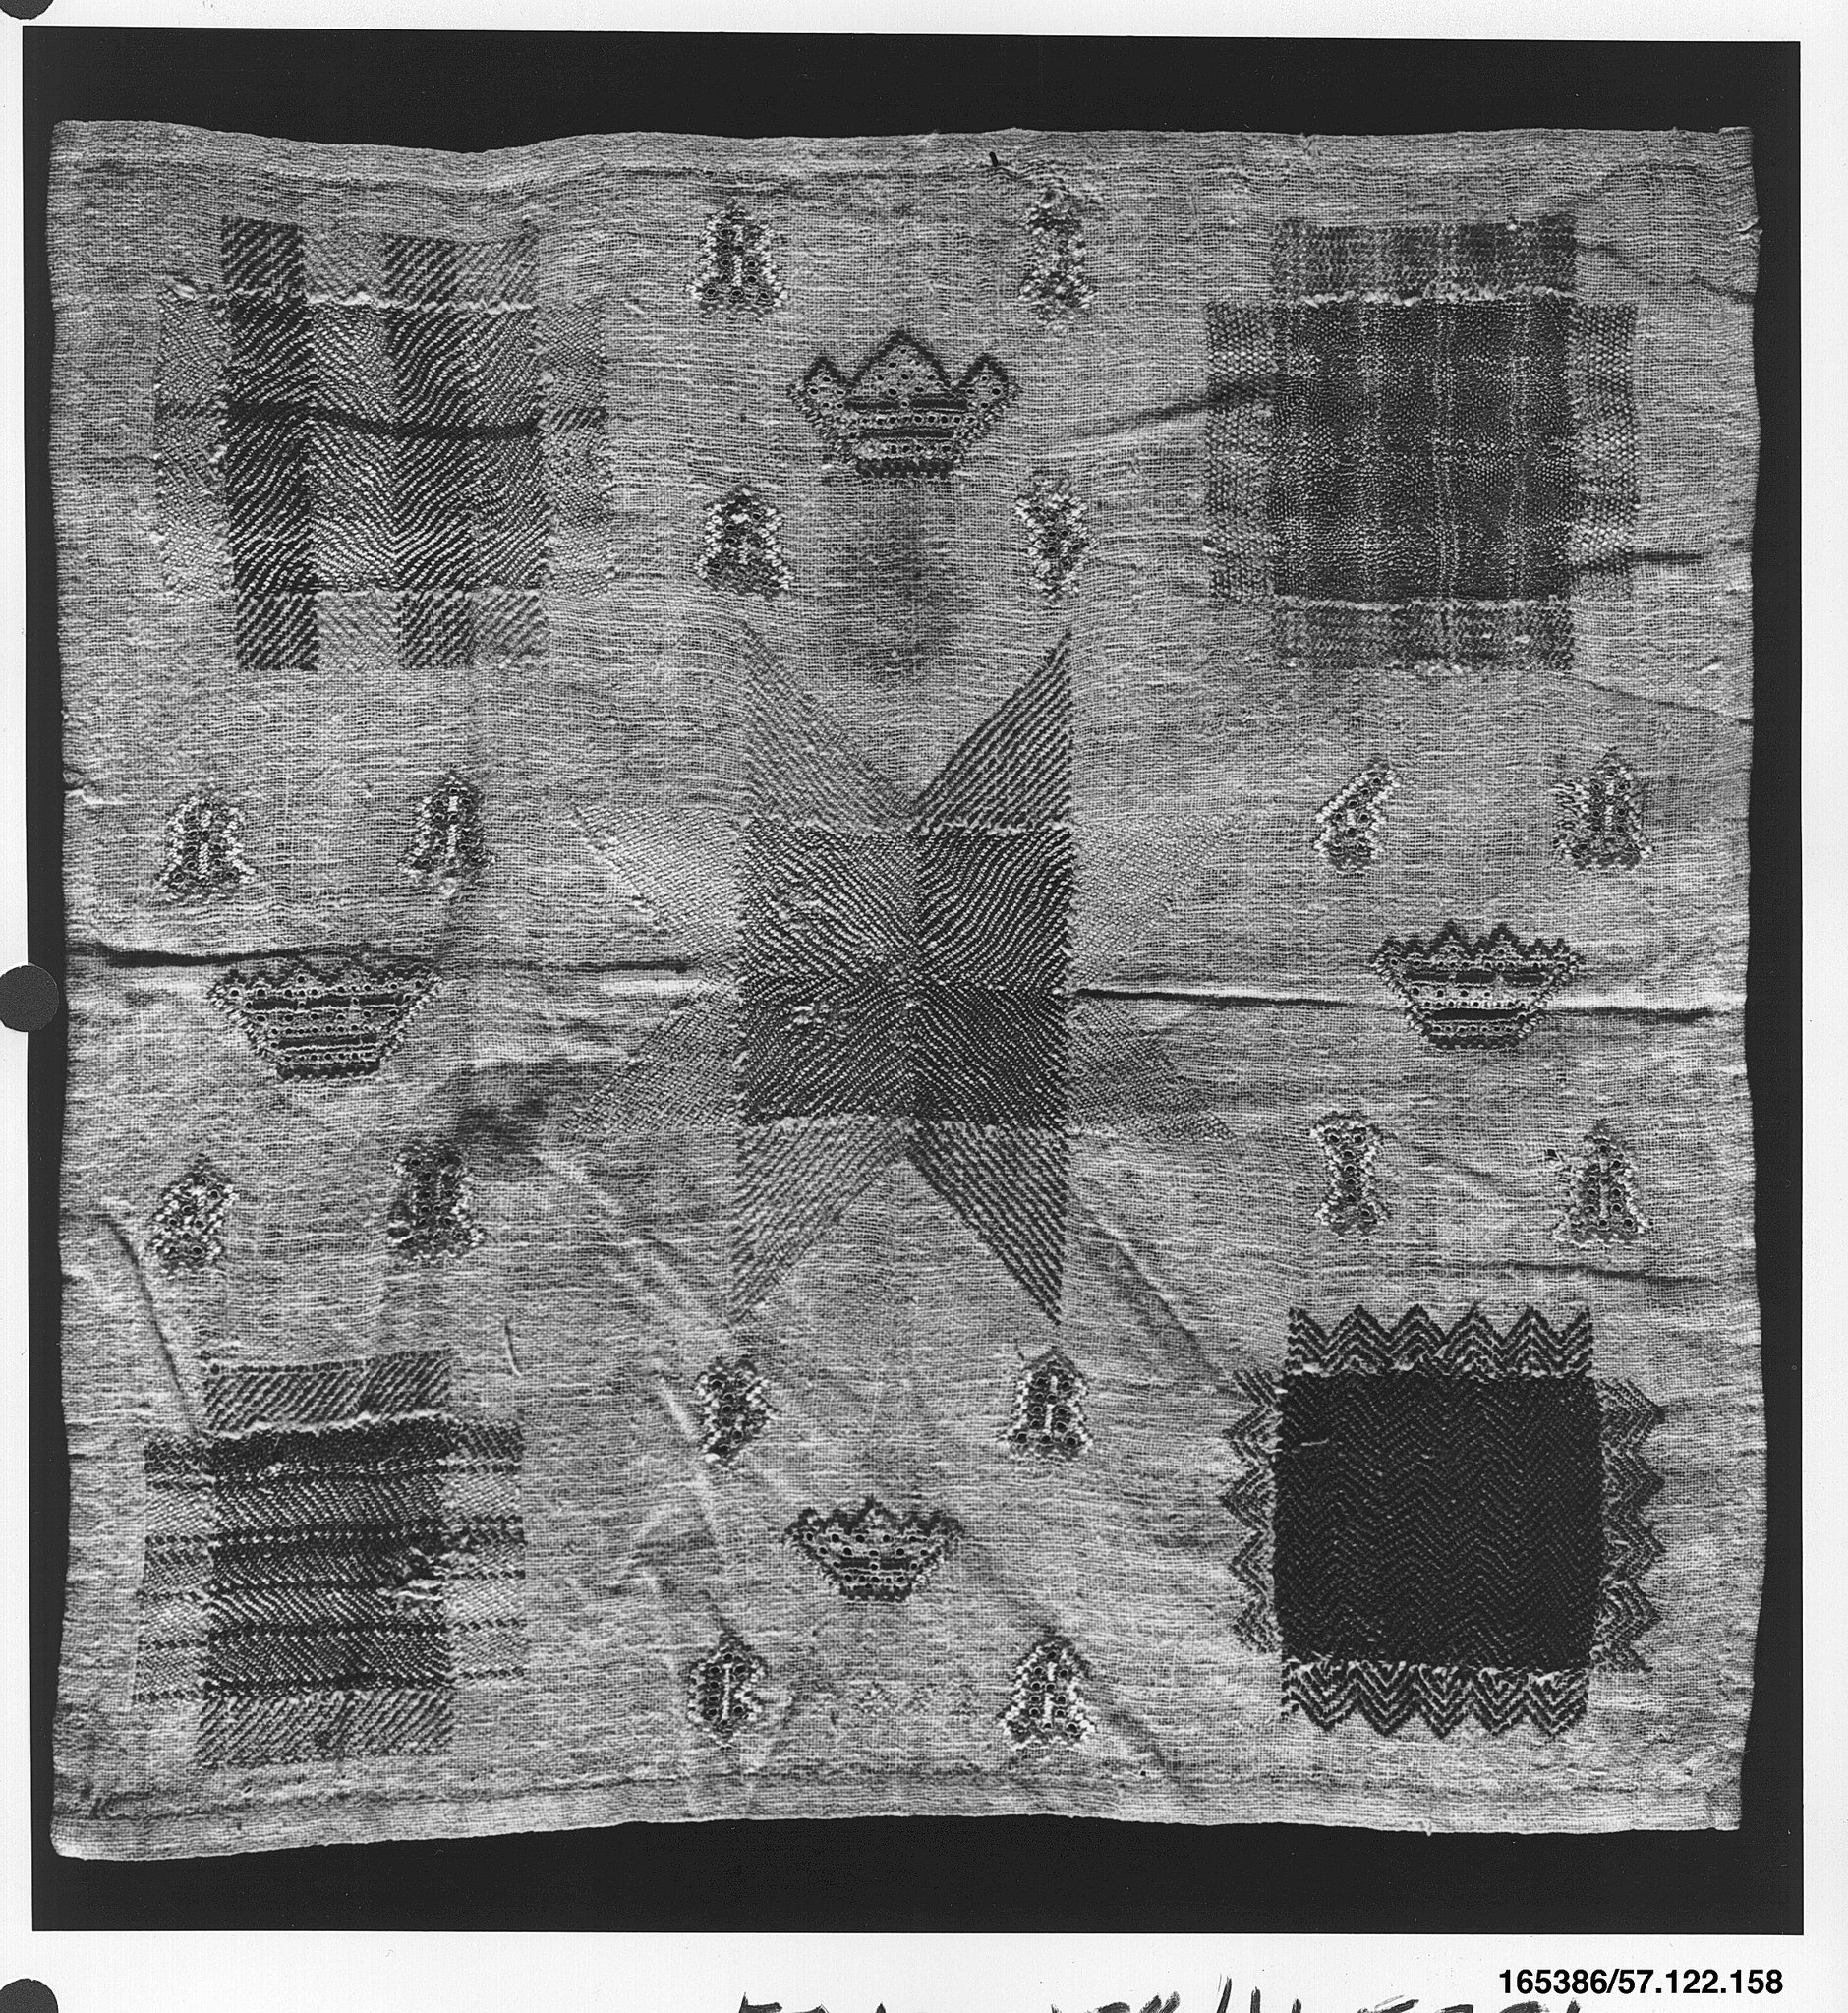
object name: sampler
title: Embroidered darning sampler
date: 1762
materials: cotton, silk